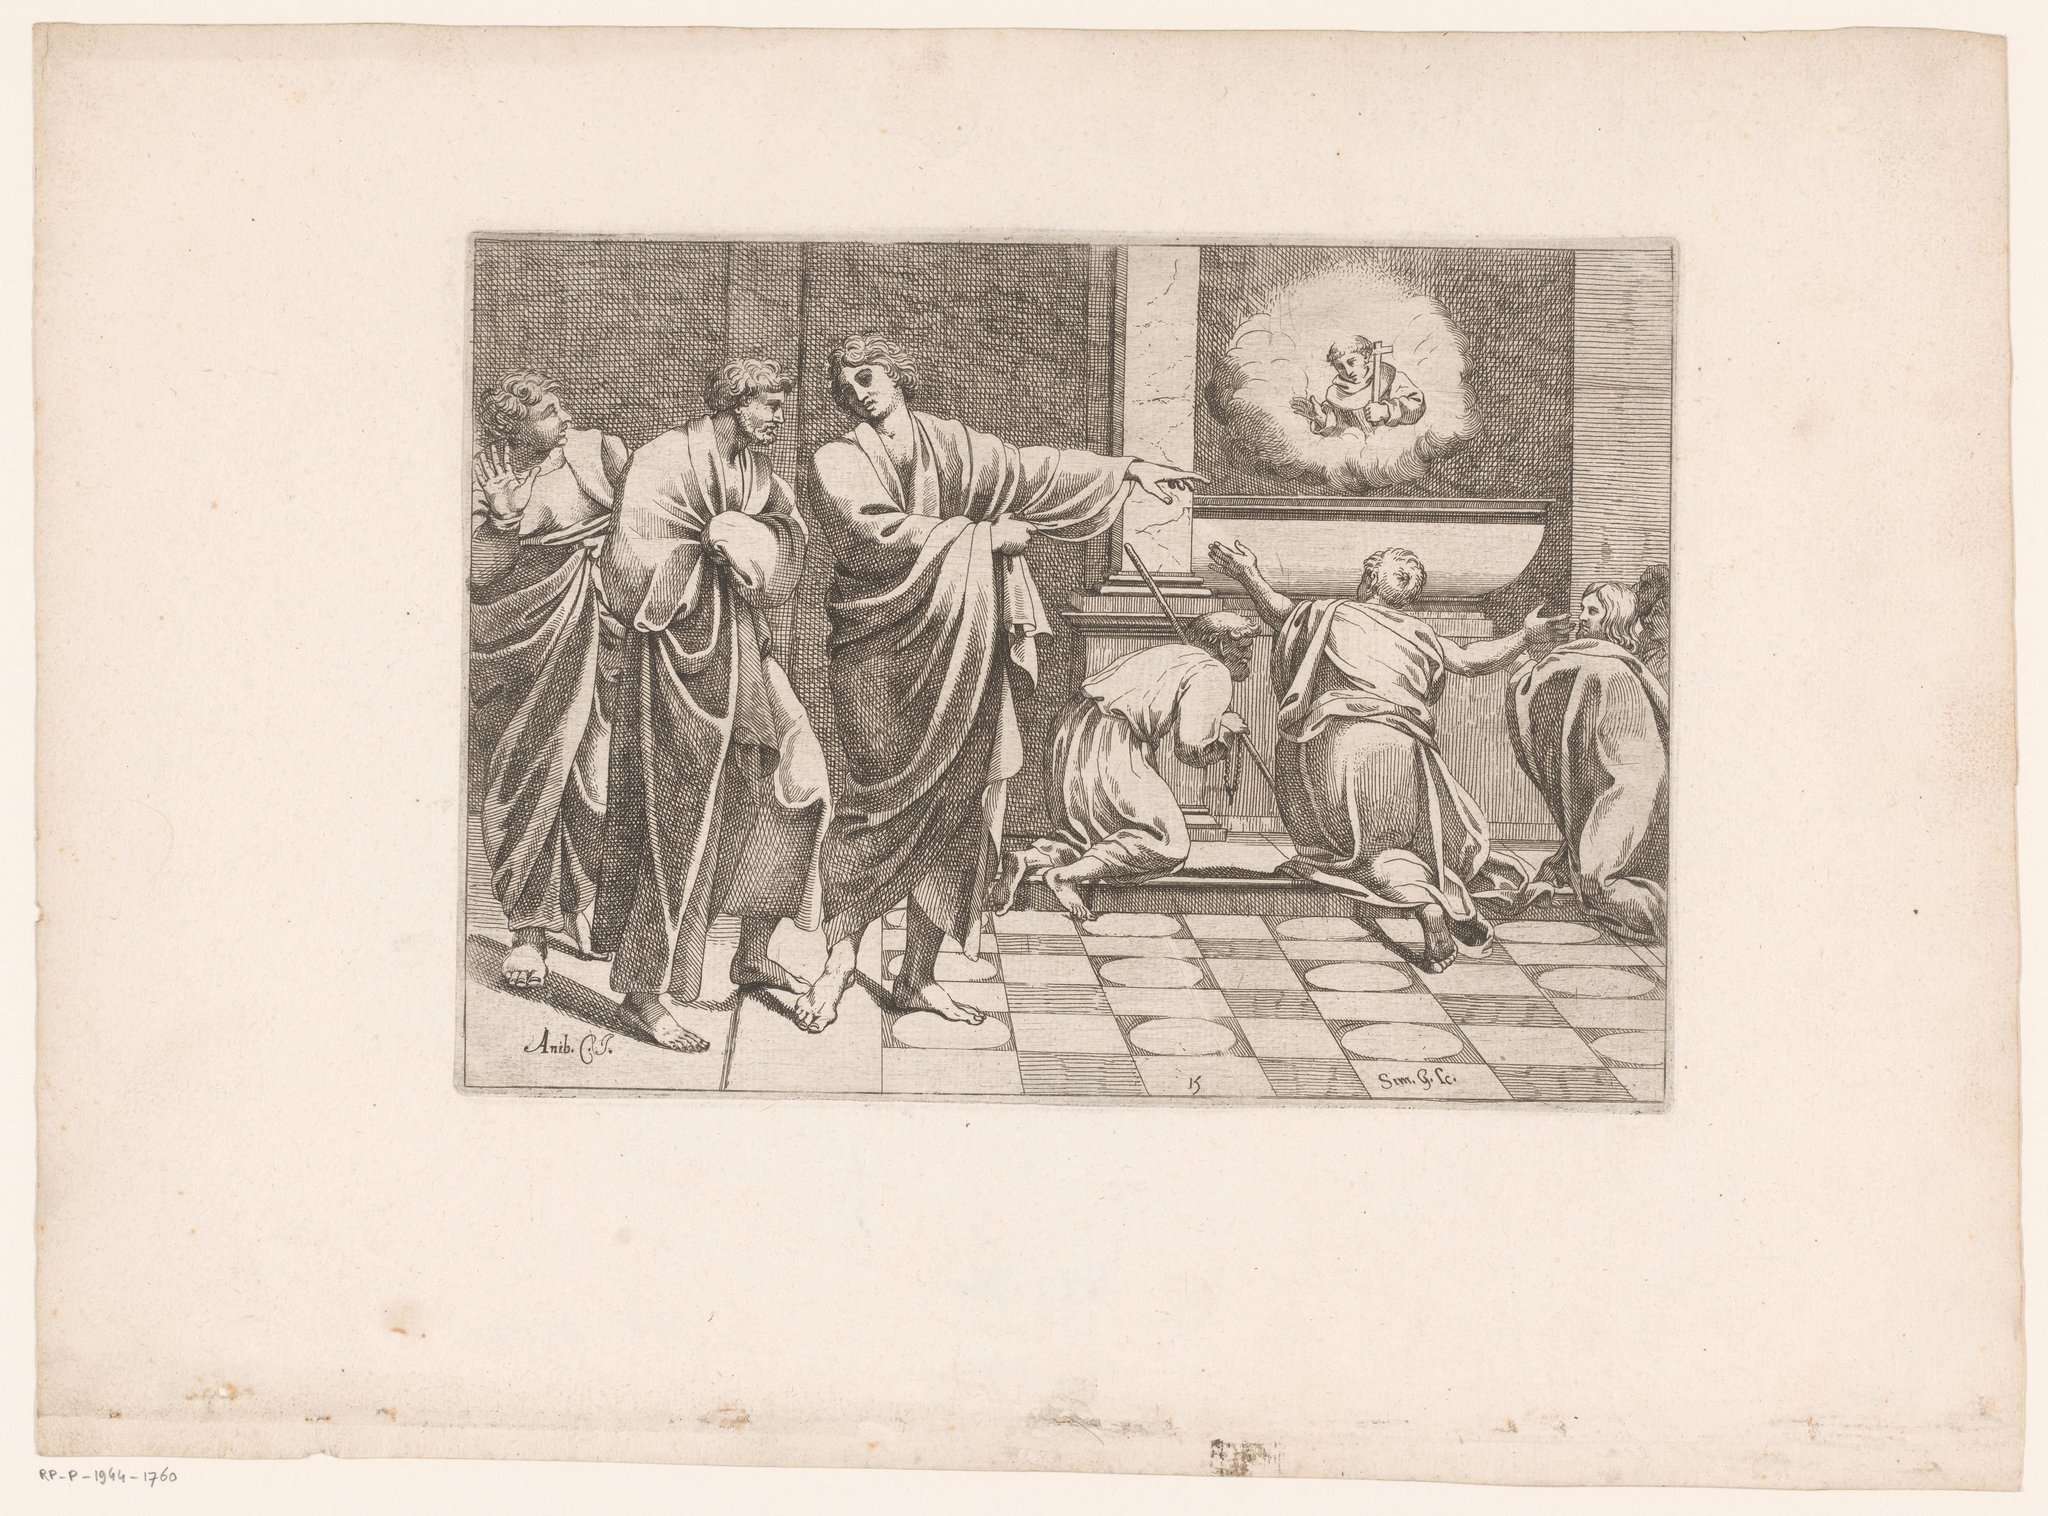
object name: print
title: Vita di San Diego dipinta nella Capella di S. Giacomo de Spagnoli a Roma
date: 1646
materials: paper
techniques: etching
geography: rome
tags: saints, grave, tomb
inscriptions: collector's mark: Lugt 2228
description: Maakt deel uit van een twintigdelige serie getiteld 'Vita di San Diego dipinta nella Capella di S. Giacomo de Spagnoli a Roma' met scènes uit het leven van Juan Diego Cuauhtlatoatzin door Annibale Carracci in Herrera kapel van de Nostra Signora del Sacro Cuore te Rome. De serie werd in 1646 uitgegeven in Rome.